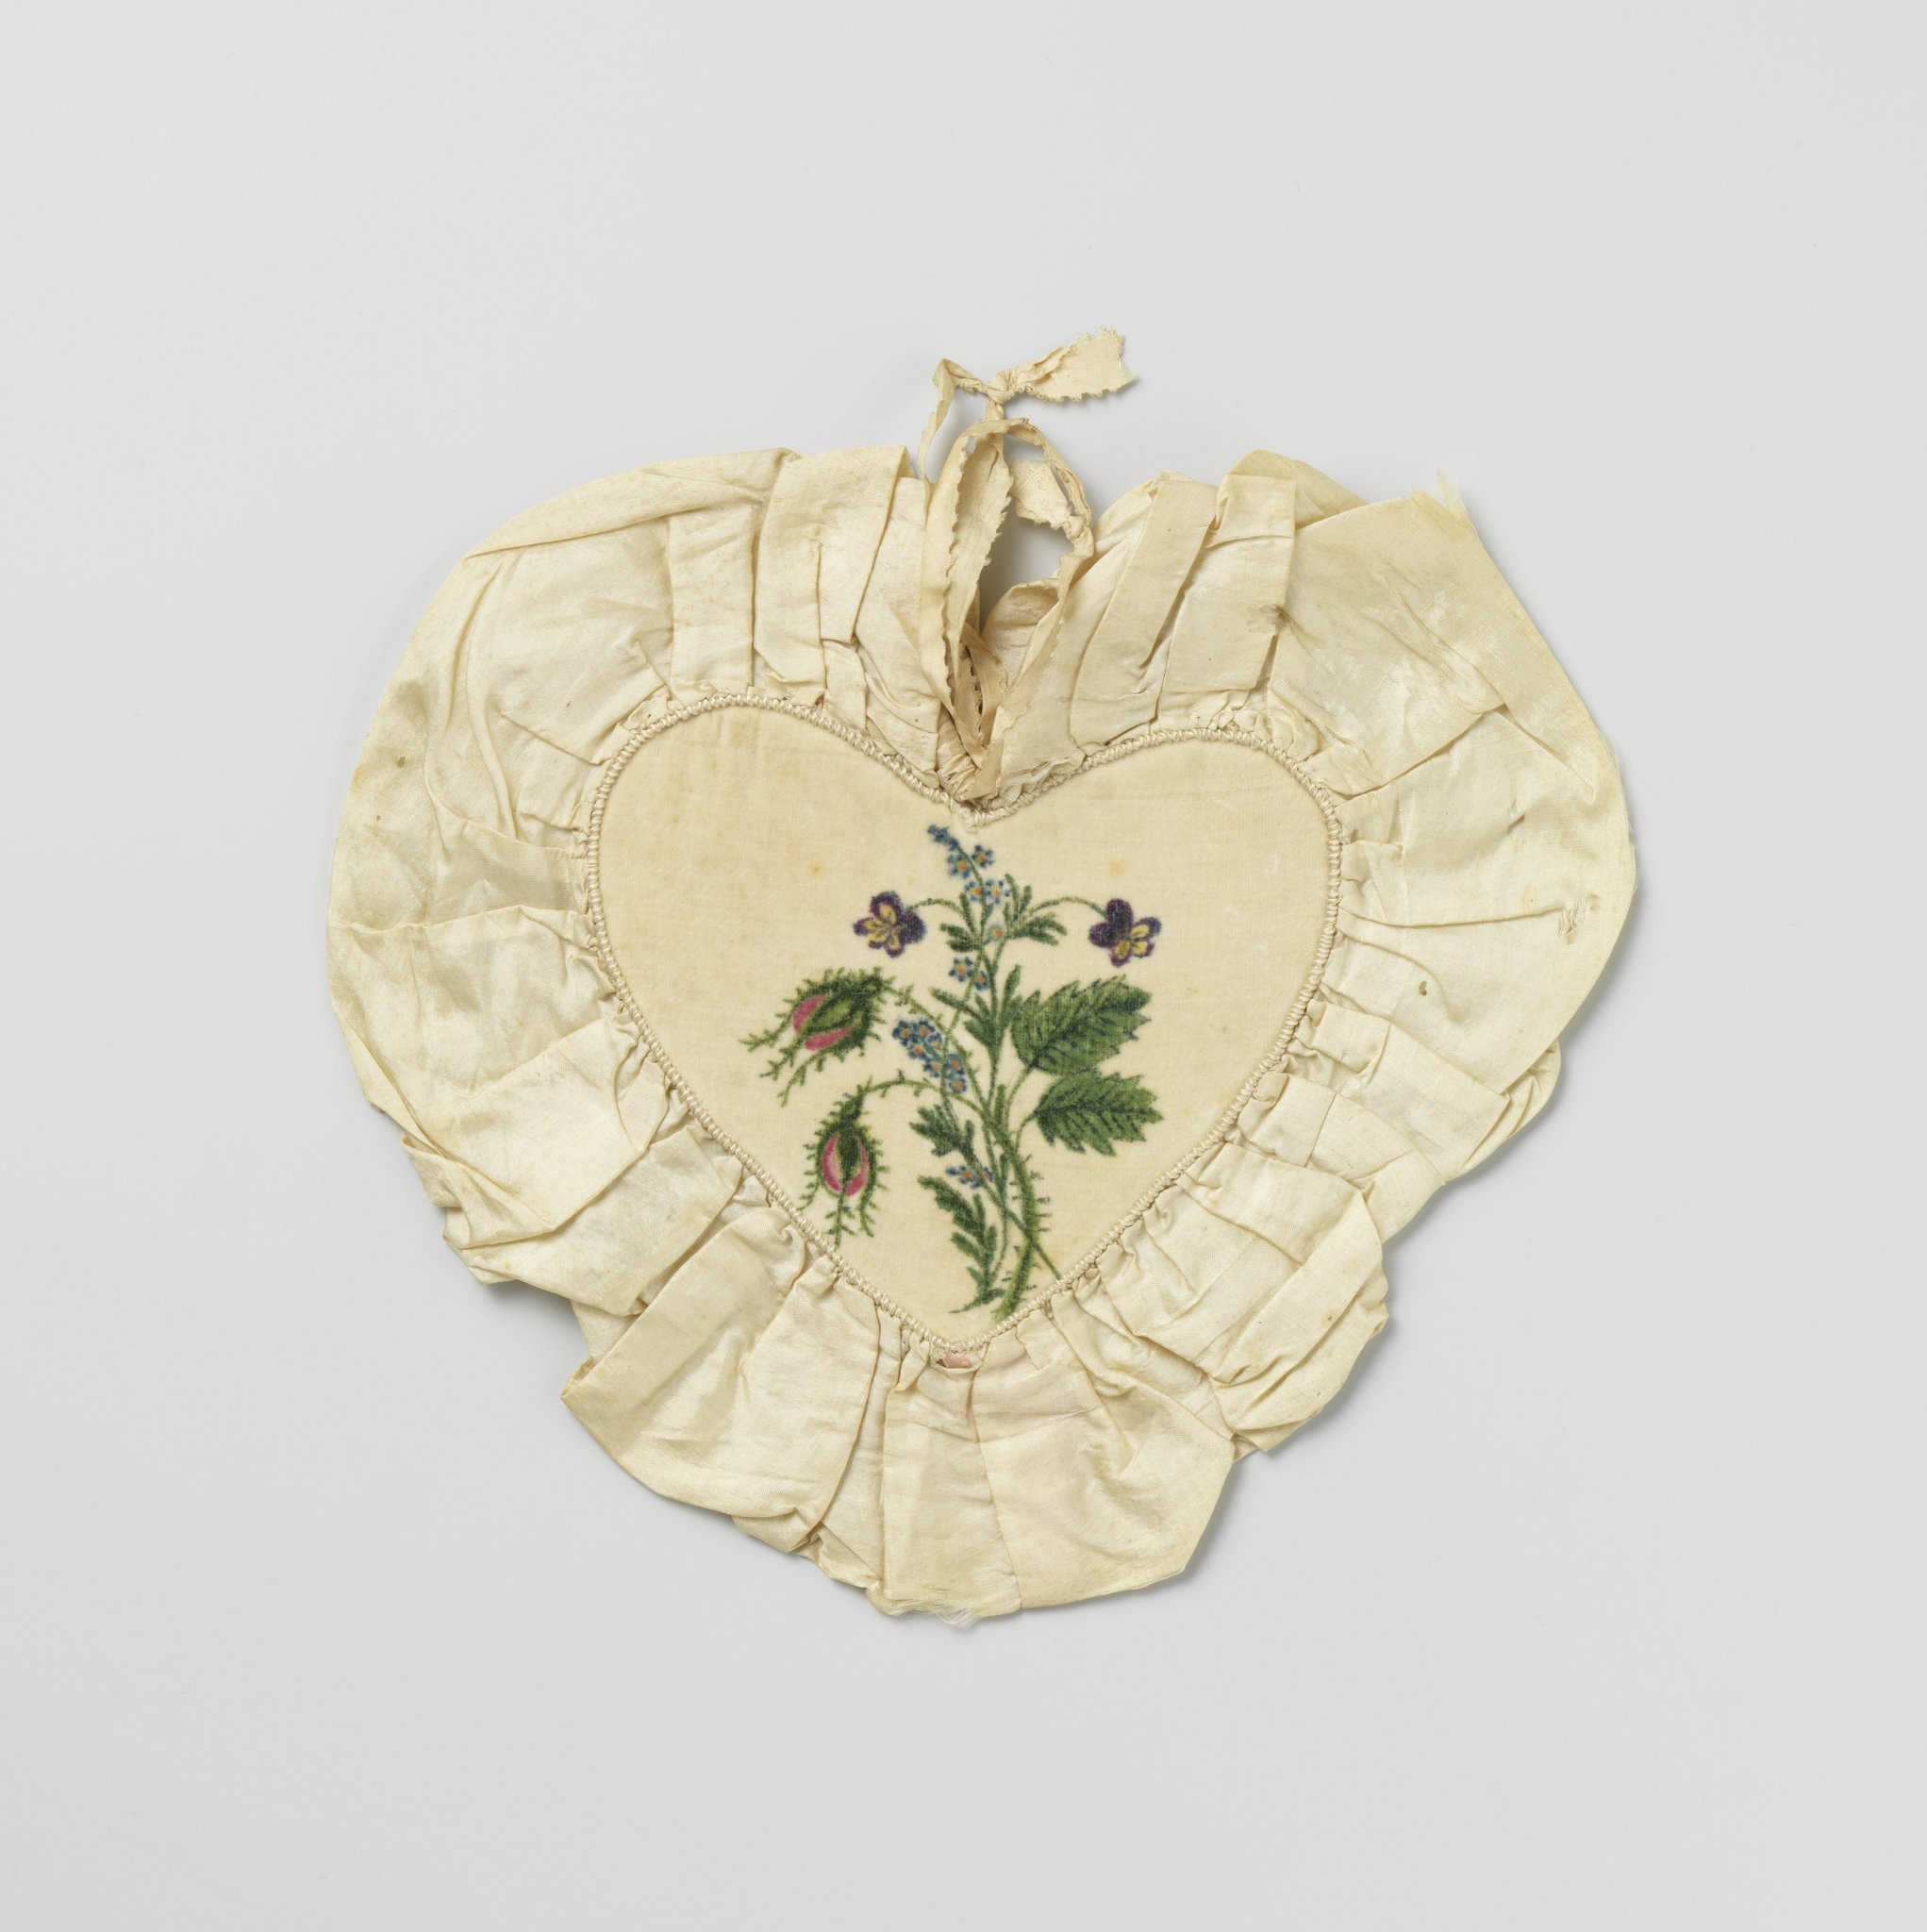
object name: bag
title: Tas samengesteld uit verstevigde twee harten bekleed met velours, met bloemen beschilderd, omgeven door een rand van crèmekleurige gerimpelde zijde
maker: Anonymous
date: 1830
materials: cardboard, linen, oil, paint, silk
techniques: weave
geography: netherlands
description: Tas samengesteld uit twee harten van karton bekleed met velours, beschilderd en omgeven door een rand van crèmekleurige gerimpelde zijde. De velours is op twee kartonnen harten genaaid. Op de velours zijn kleurige bloemmotieven geschilderd: op het ene blad een krans van viooltjes en vergeet-me-nietjes, afgewisseld met bladgroen; op het andere, een boeket van viooltjes, vergeet-me-nietjes en distels (?). Boven aan ieder blad een klein zijden lint als handvat. De kartonnen harten zijn aan de achter- c.q. binnenkant afgewerkt met wit linnen.